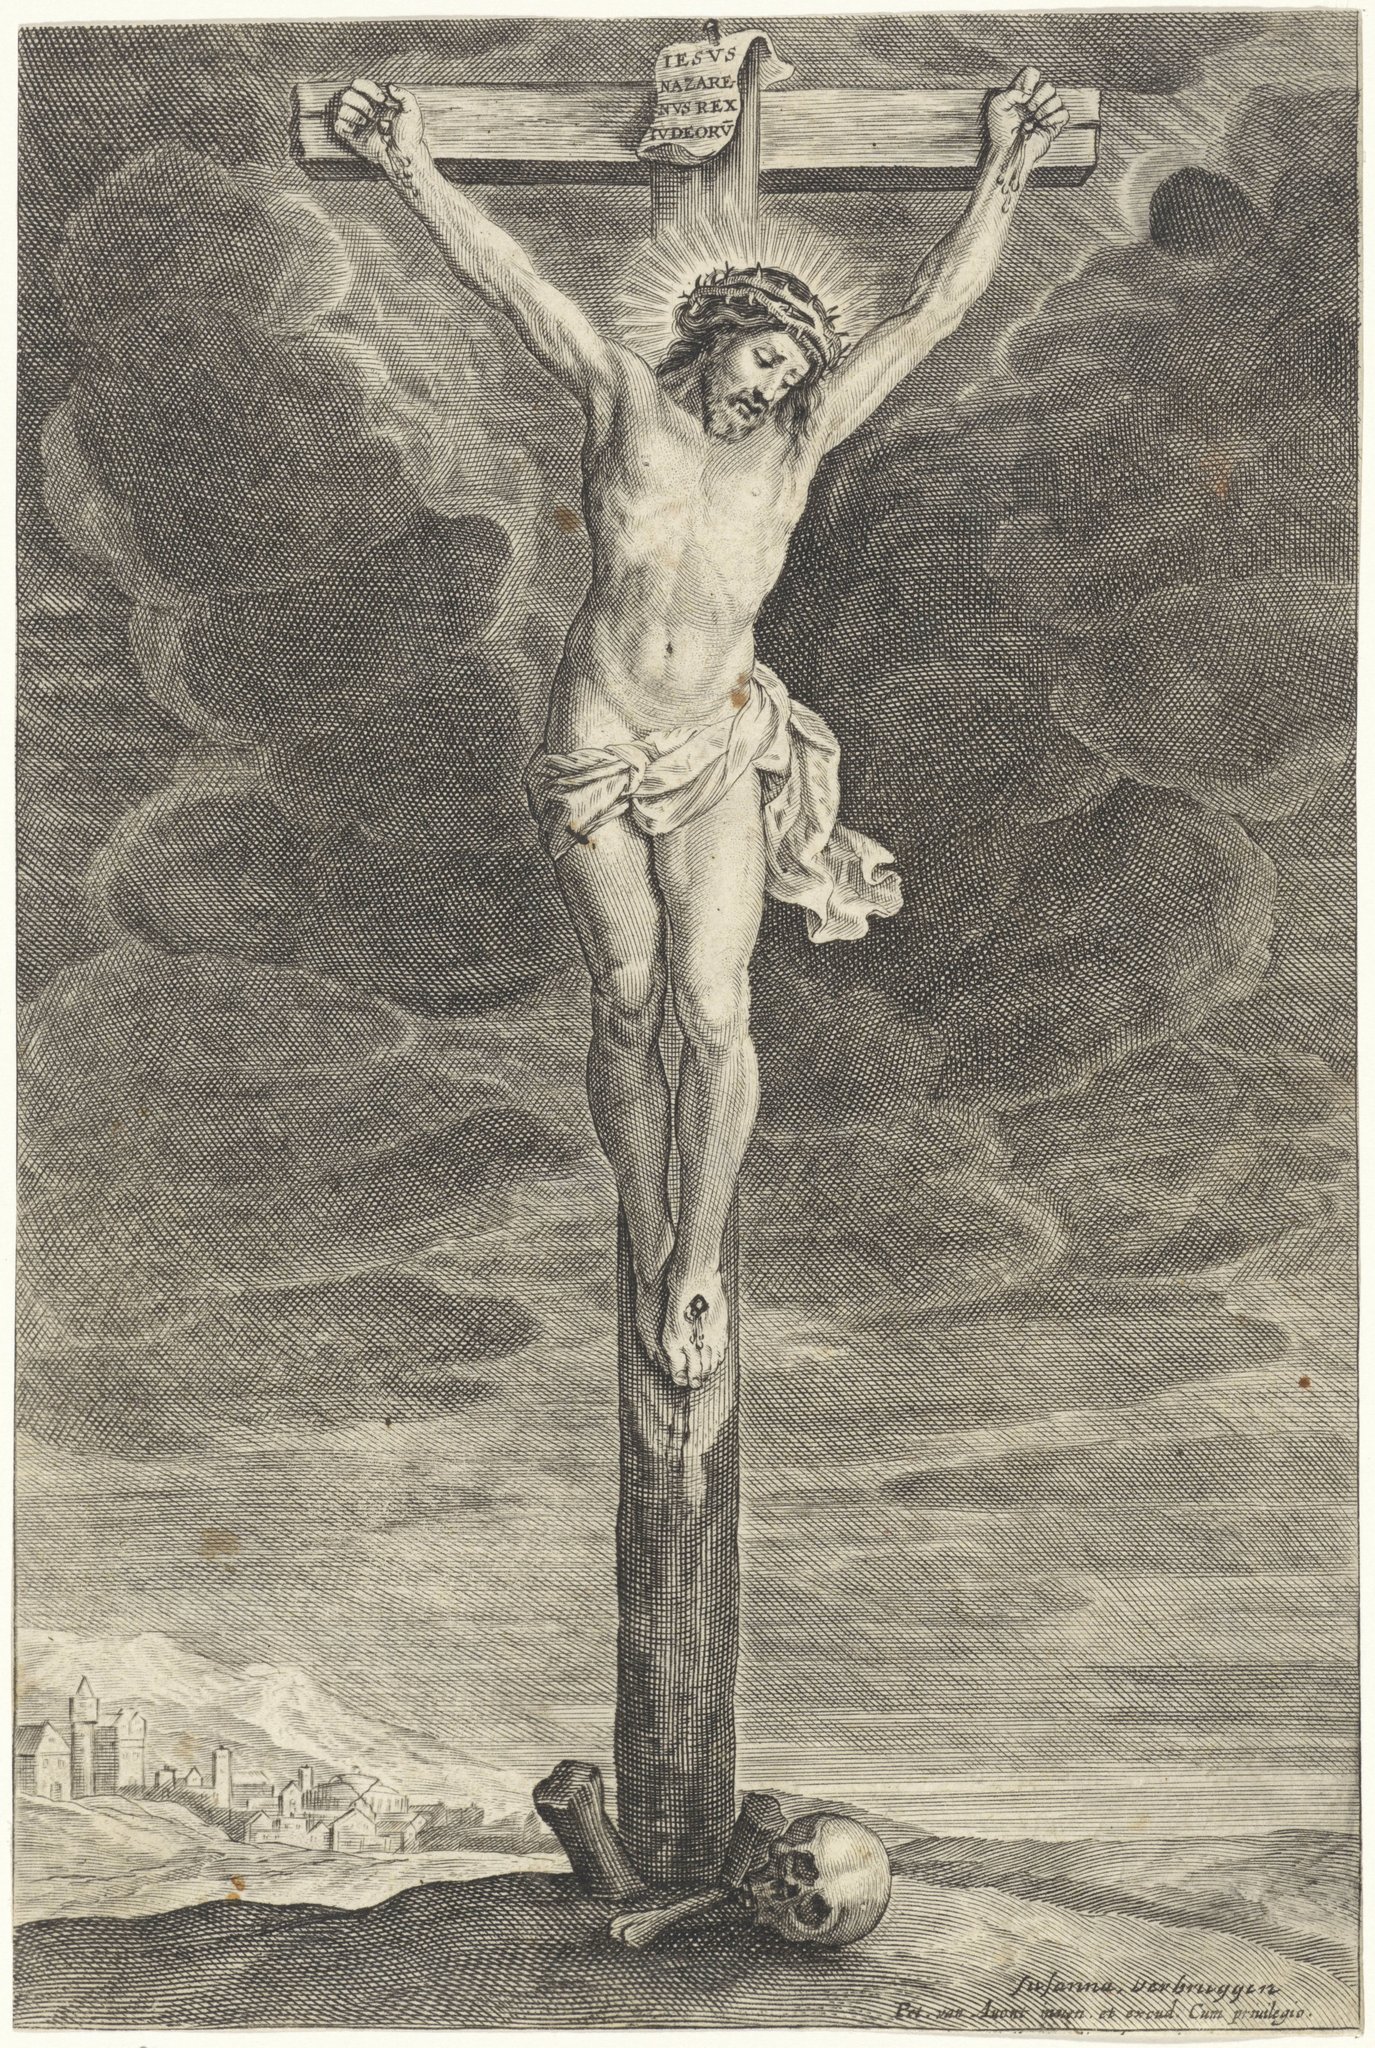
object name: print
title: Christus aan het kruis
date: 1622-1652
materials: paper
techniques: engraving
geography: antwerp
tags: the crucifixion of christ: christ's death on the cross; golgotha (matthew 27:45-58; mark 15:33-45; luke 23:44-52; john 19:25-38)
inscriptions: collector's mark: Lugt 2228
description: Christus aan het kruis, aan de voet daarvan een schedel en gebeente. Links in het verschiet Jeruzalem.